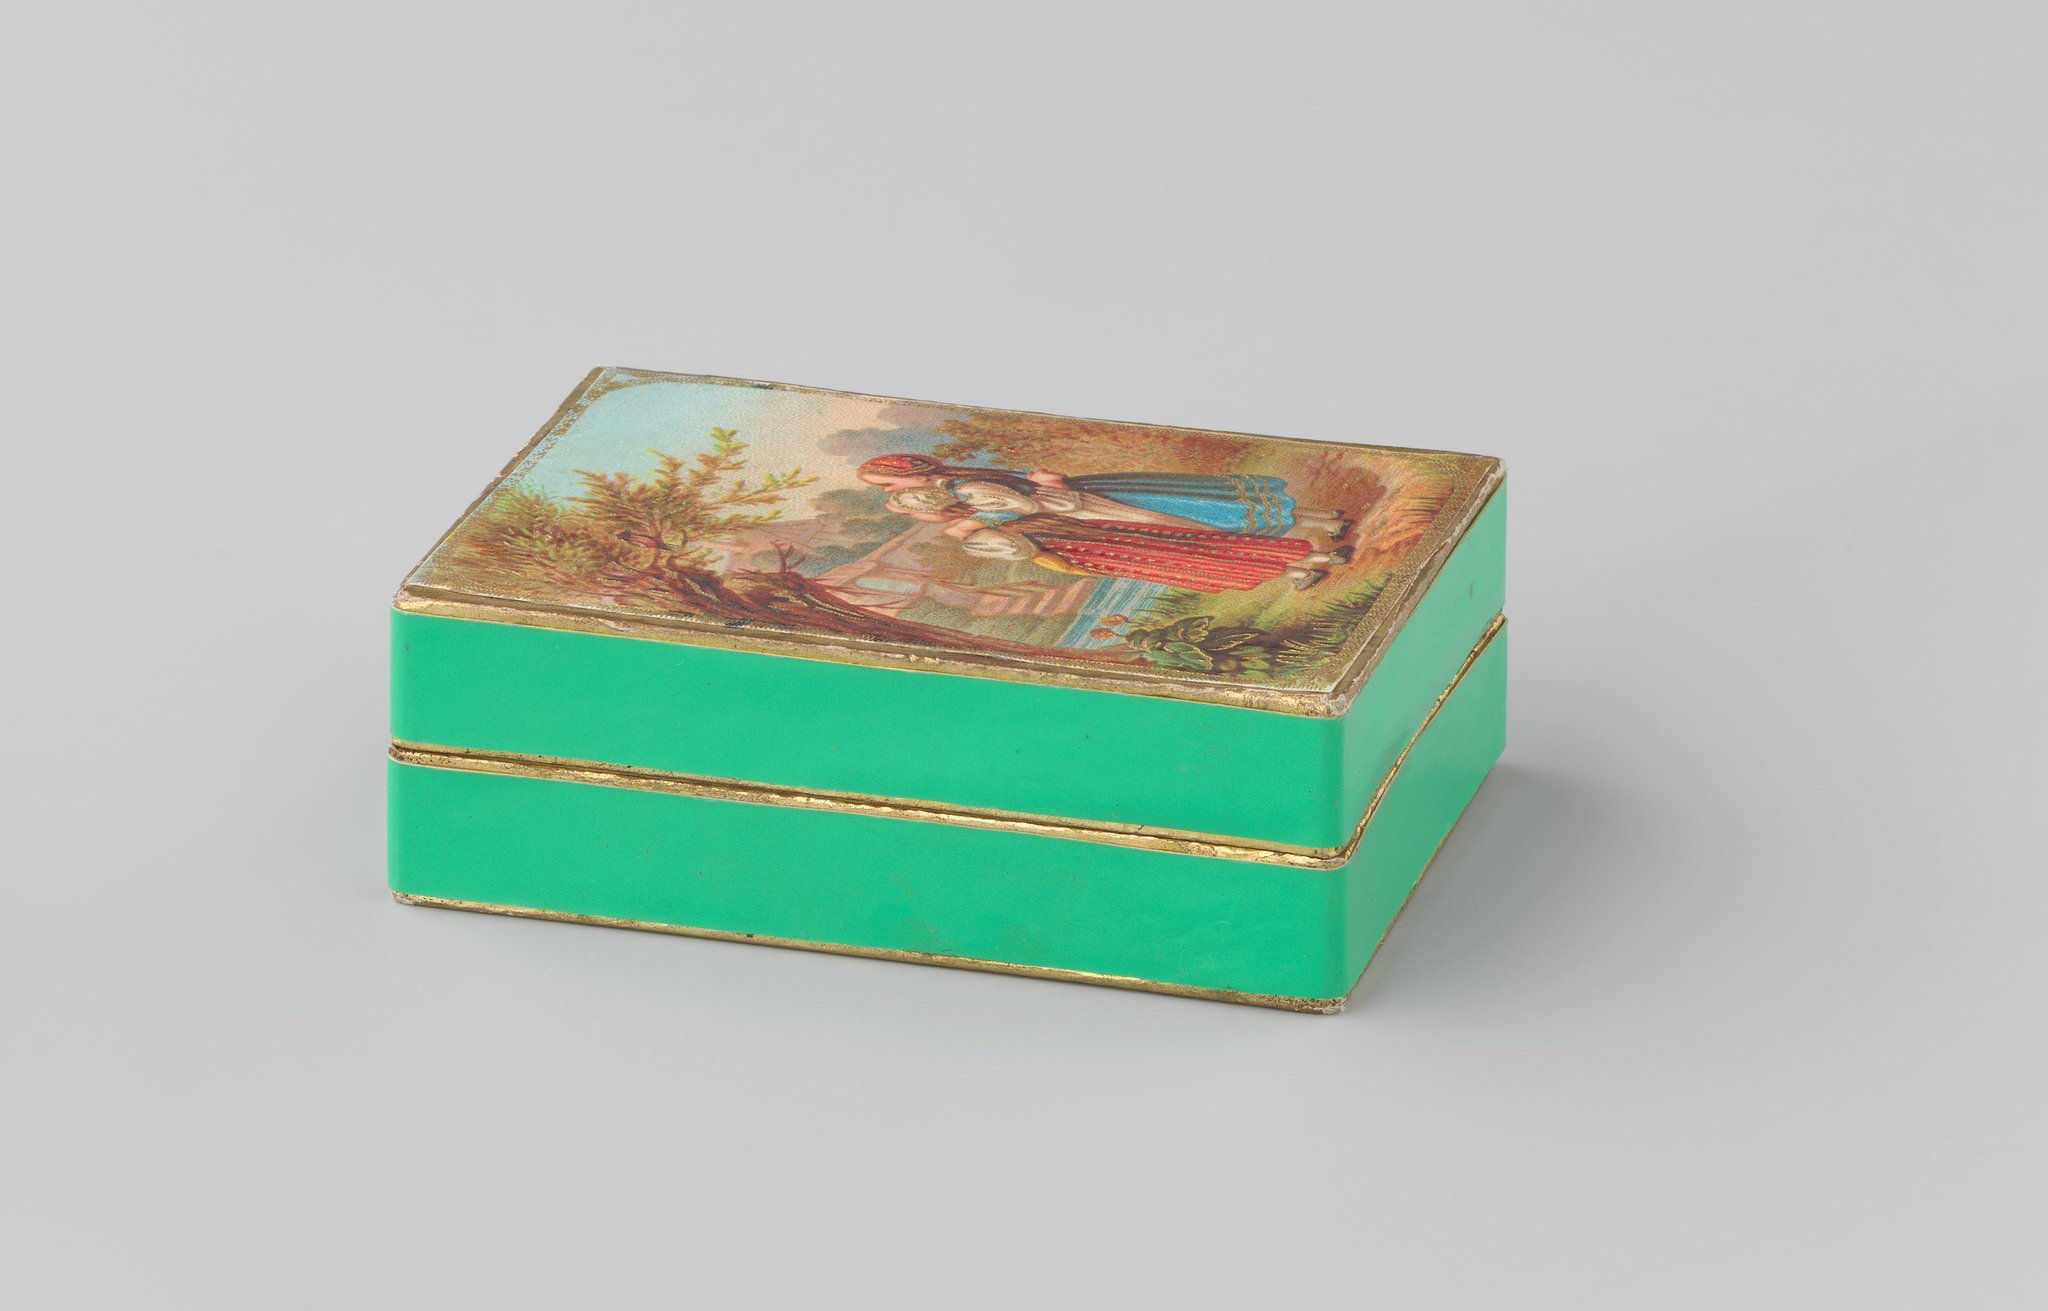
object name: poppengoed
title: Doos met afbeelding van twee meisjes die naar een vogel in een boom kijken.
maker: Anonymous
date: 1880-1890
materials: cardboard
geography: netherlands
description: Doos met afbeelding van twee meisjes die naar een vogel in een boom kijken. Adres: Chocoladefabriek J.H. Dekker, Boommarkt, Amsterdam. Met inhoud (BK-15446-7-b t/m 7-E).